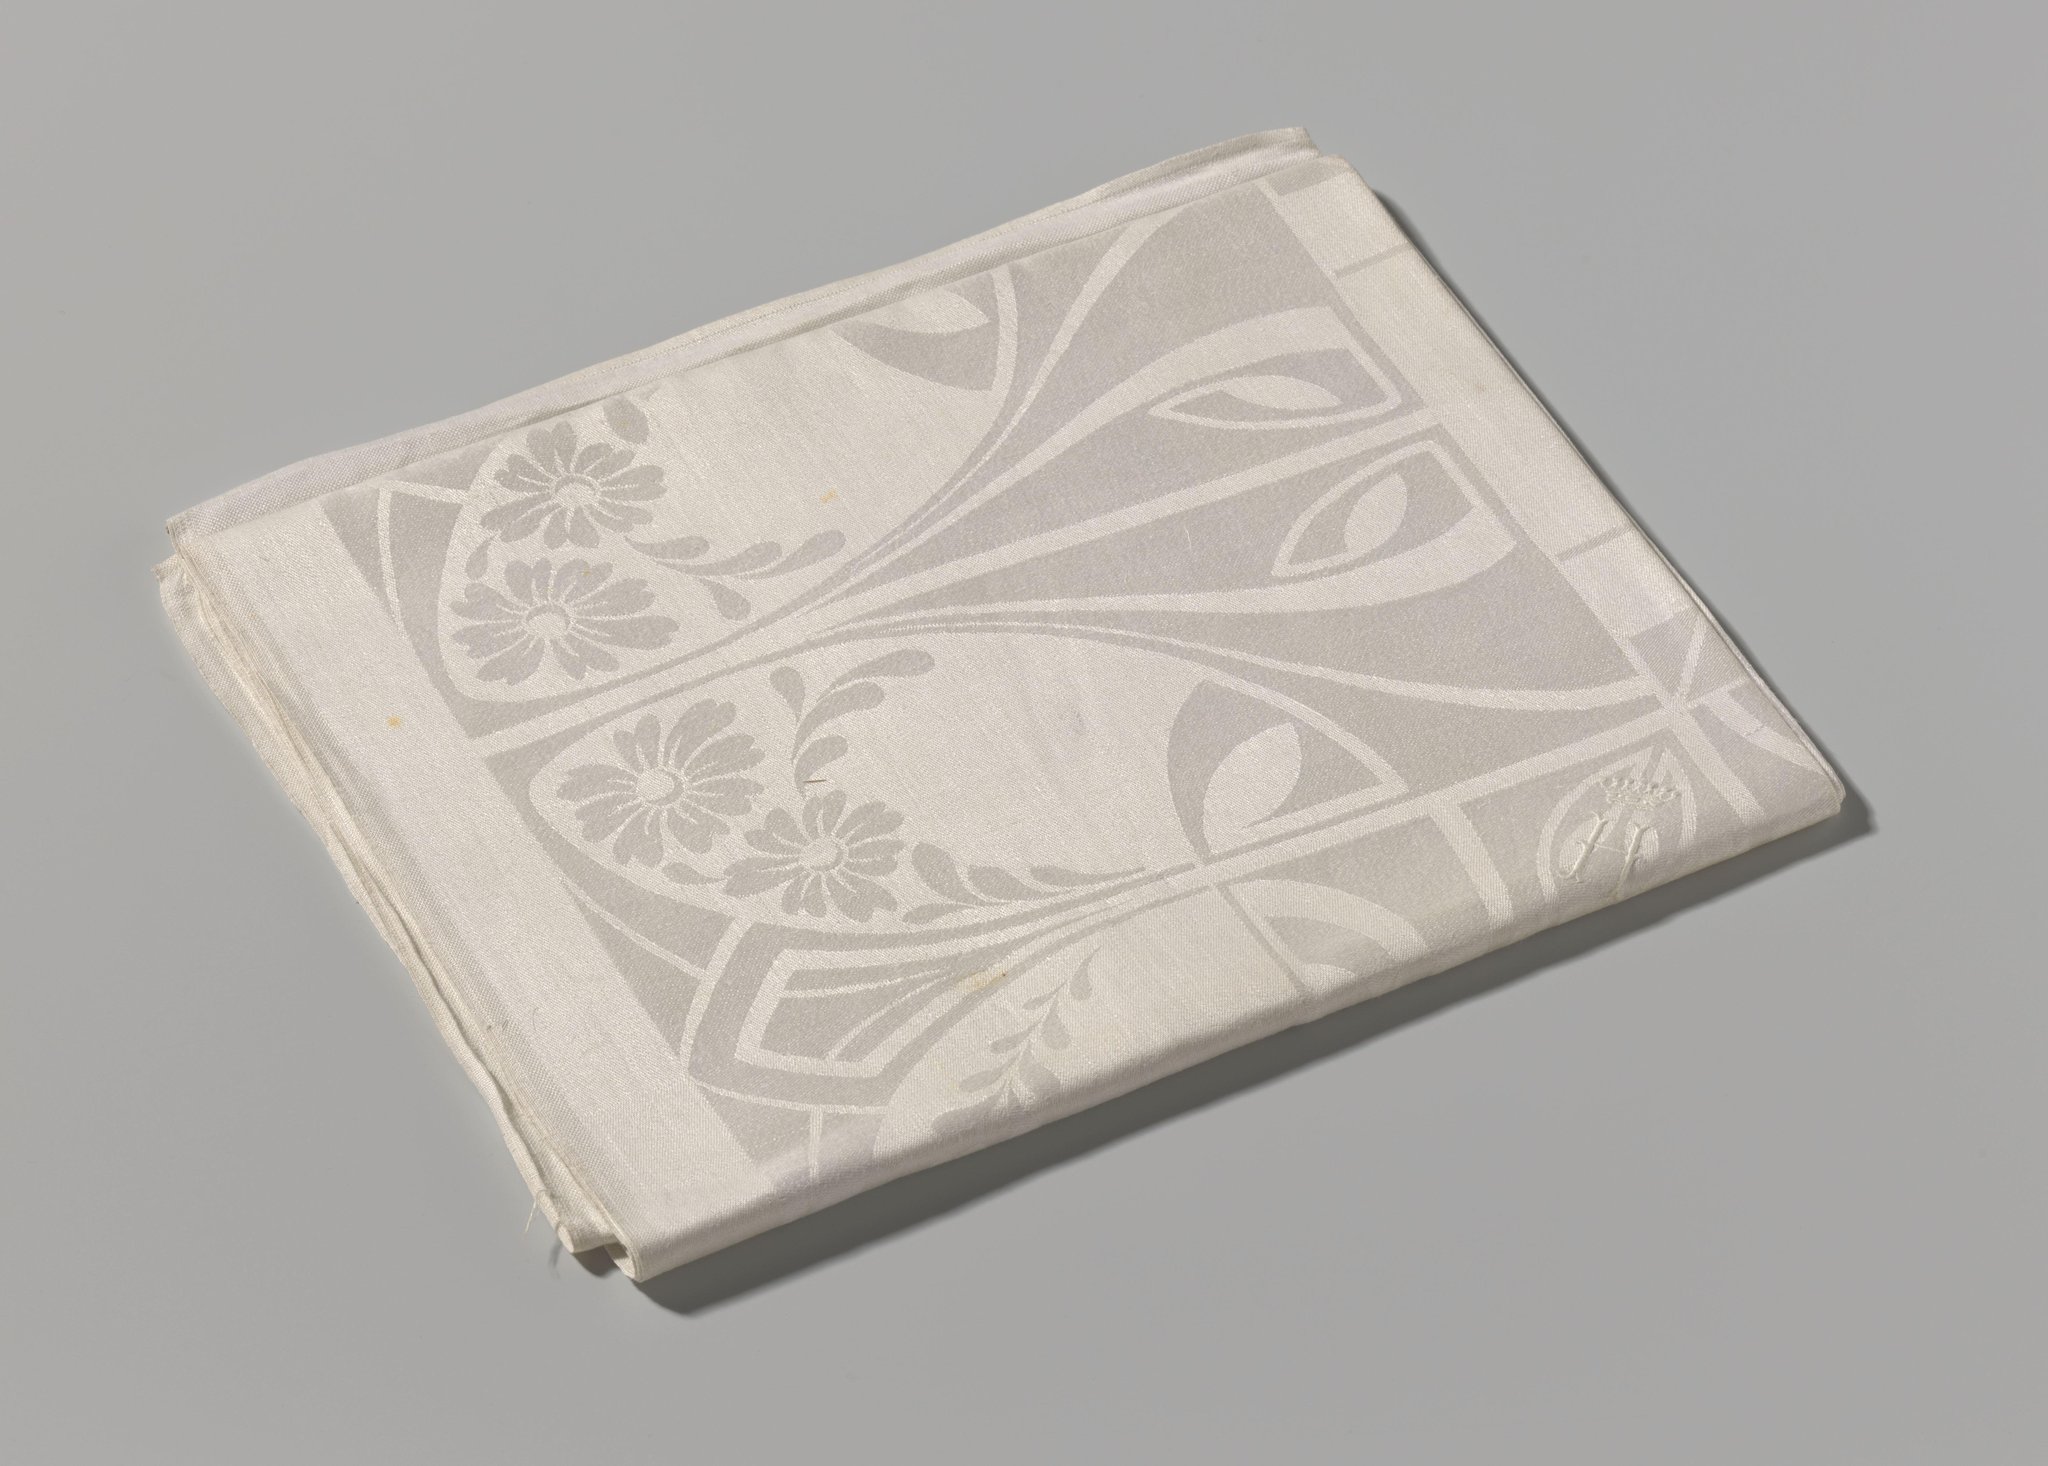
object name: tablecloth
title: Tafellaken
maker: Anonymous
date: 1900-1930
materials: linen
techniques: damask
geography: netherlands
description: Wit linnen damasten tafellaken met een patroon van kransen en rand van bloemen en Jungendstil-motieven.